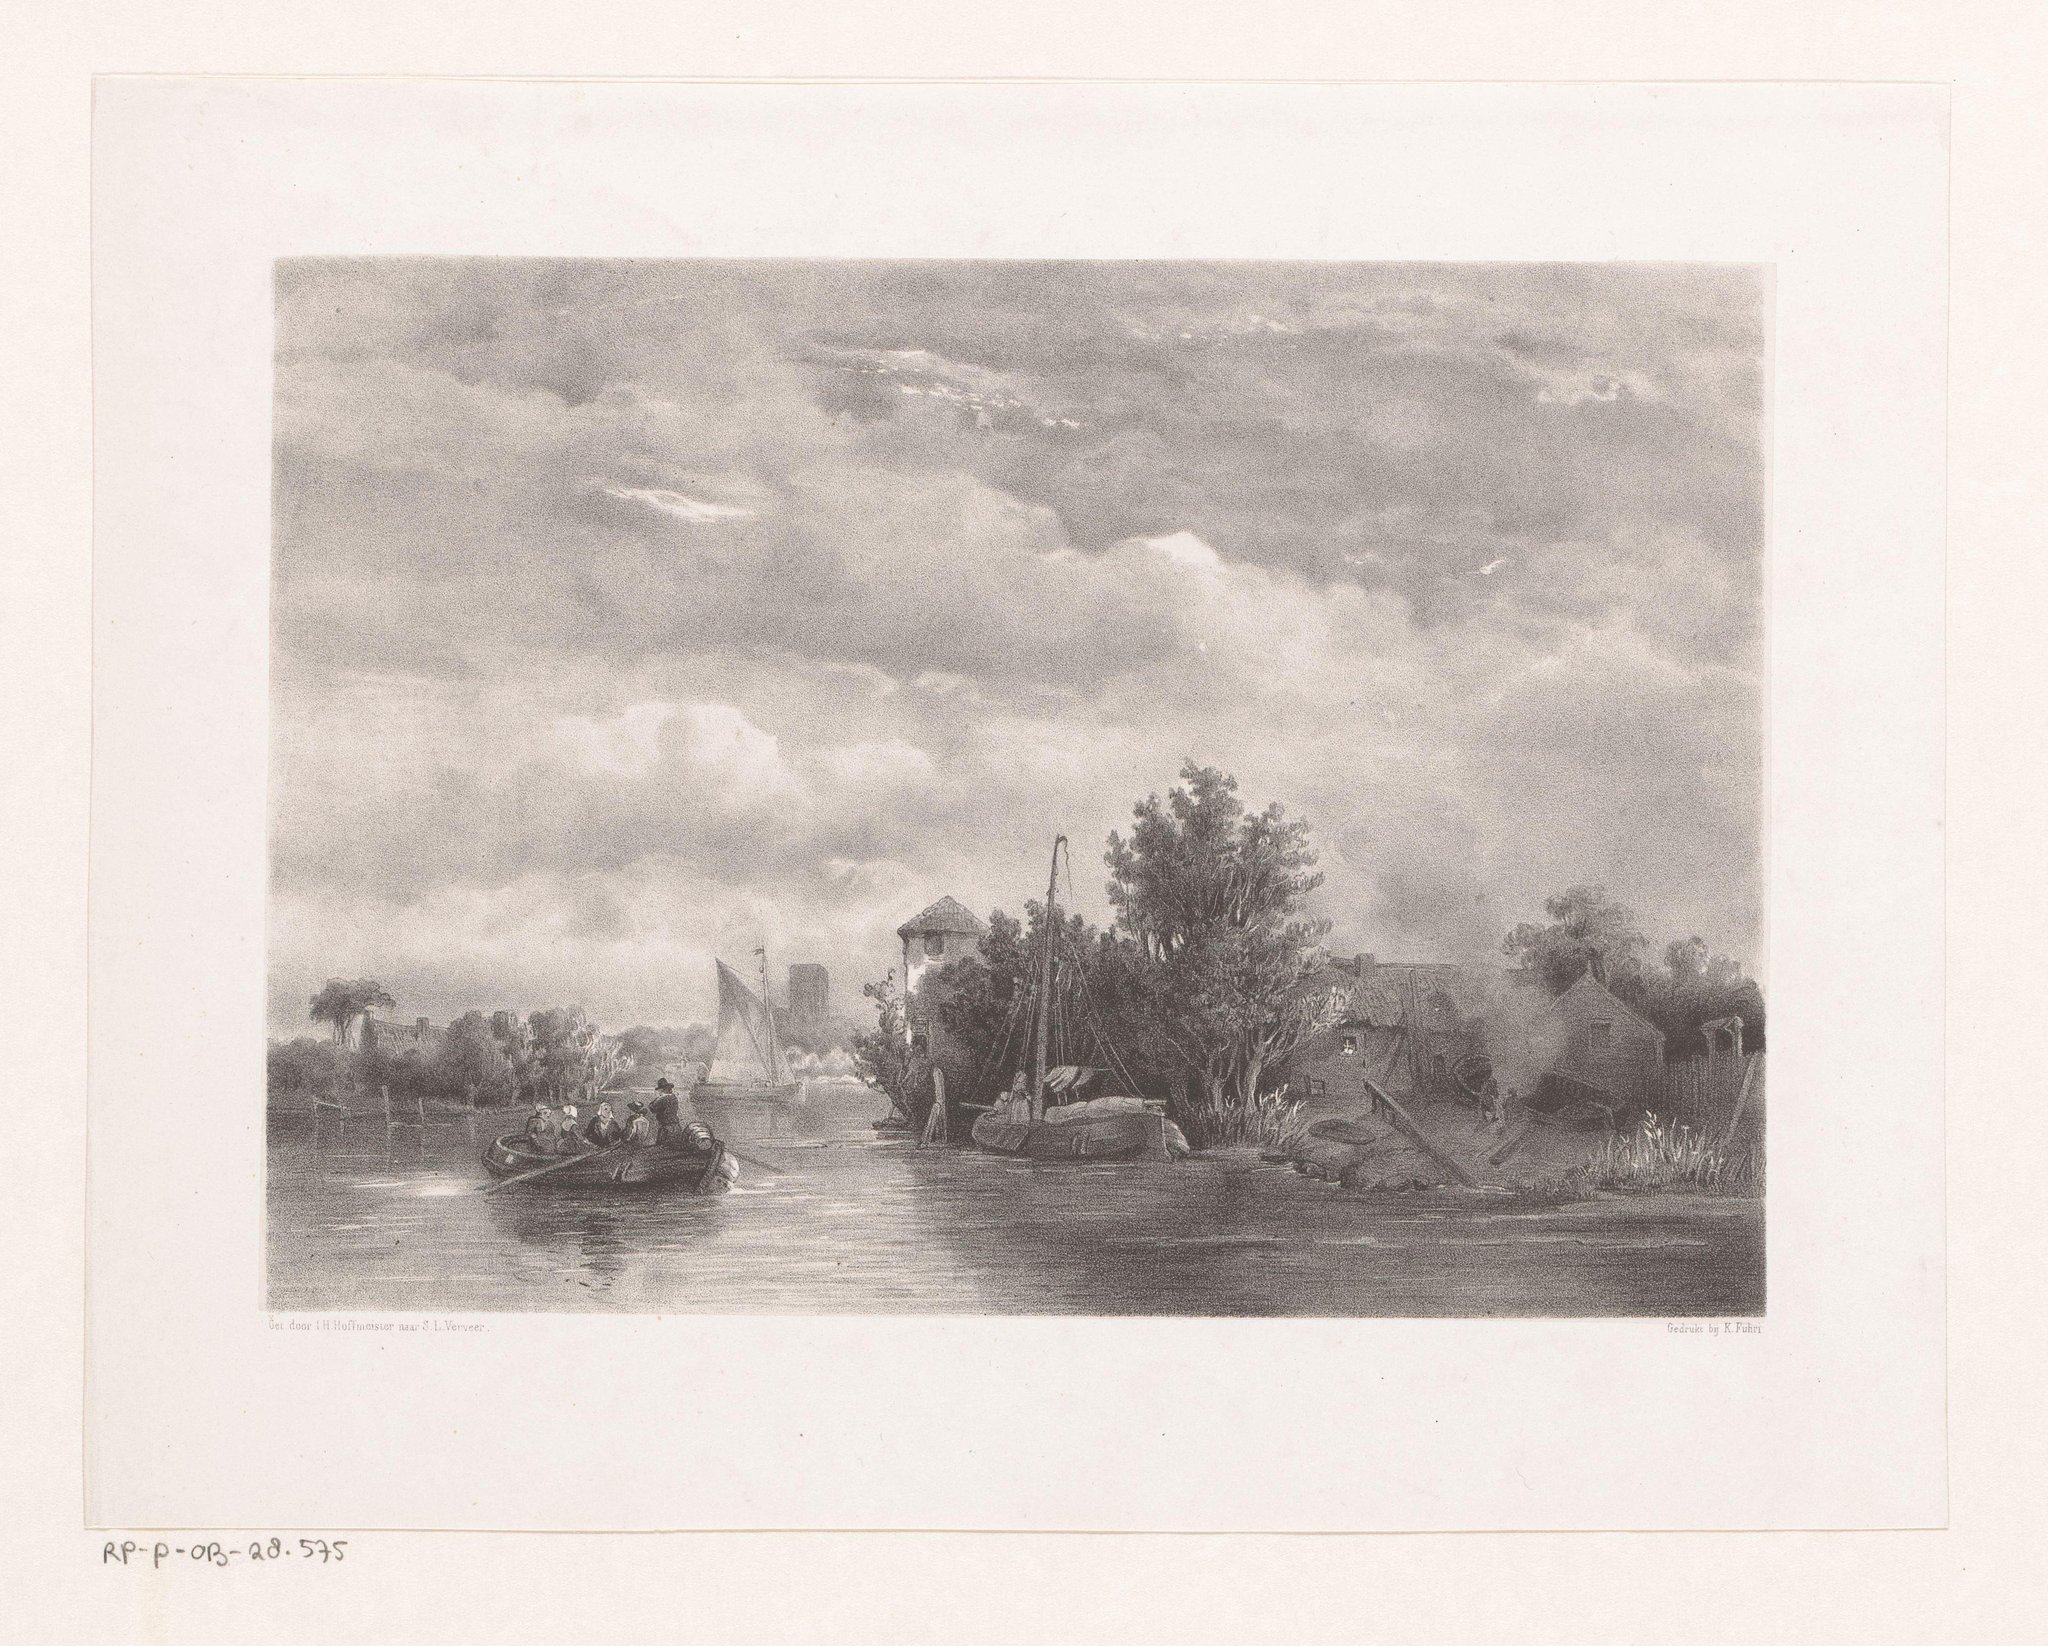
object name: print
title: Landschap met rivier, boten en huizen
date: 1843-1853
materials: paper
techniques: lithograph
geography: the hague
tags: repairing, caulking, careening (~ ship), river (+ landscape with figures, staffage)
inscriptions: collector's mark: Lugt 2228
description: Rechts op de oever is een man bezig een boot te teren. Op de rivier vaart een roeiboot met twee mannen en drie vrouwen.